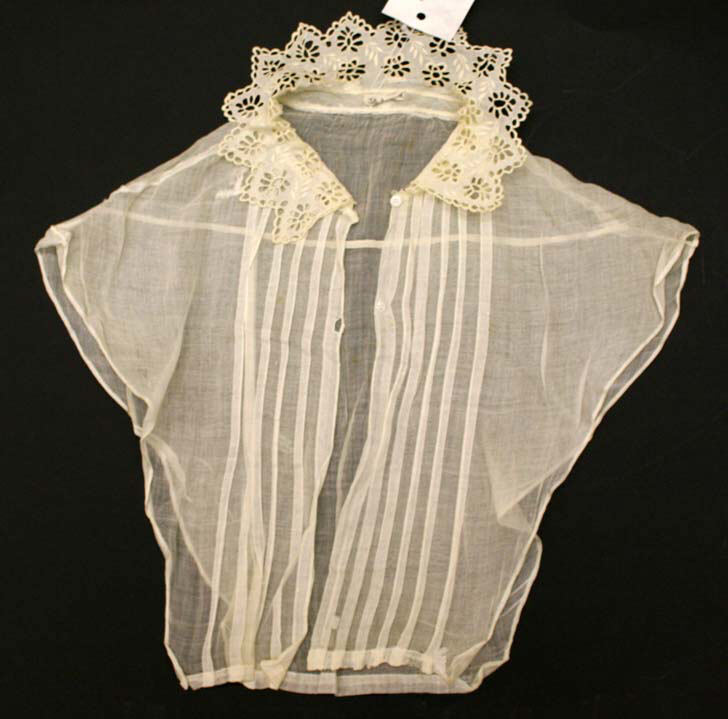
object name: vestee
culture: european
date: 1850-1859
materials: cotton